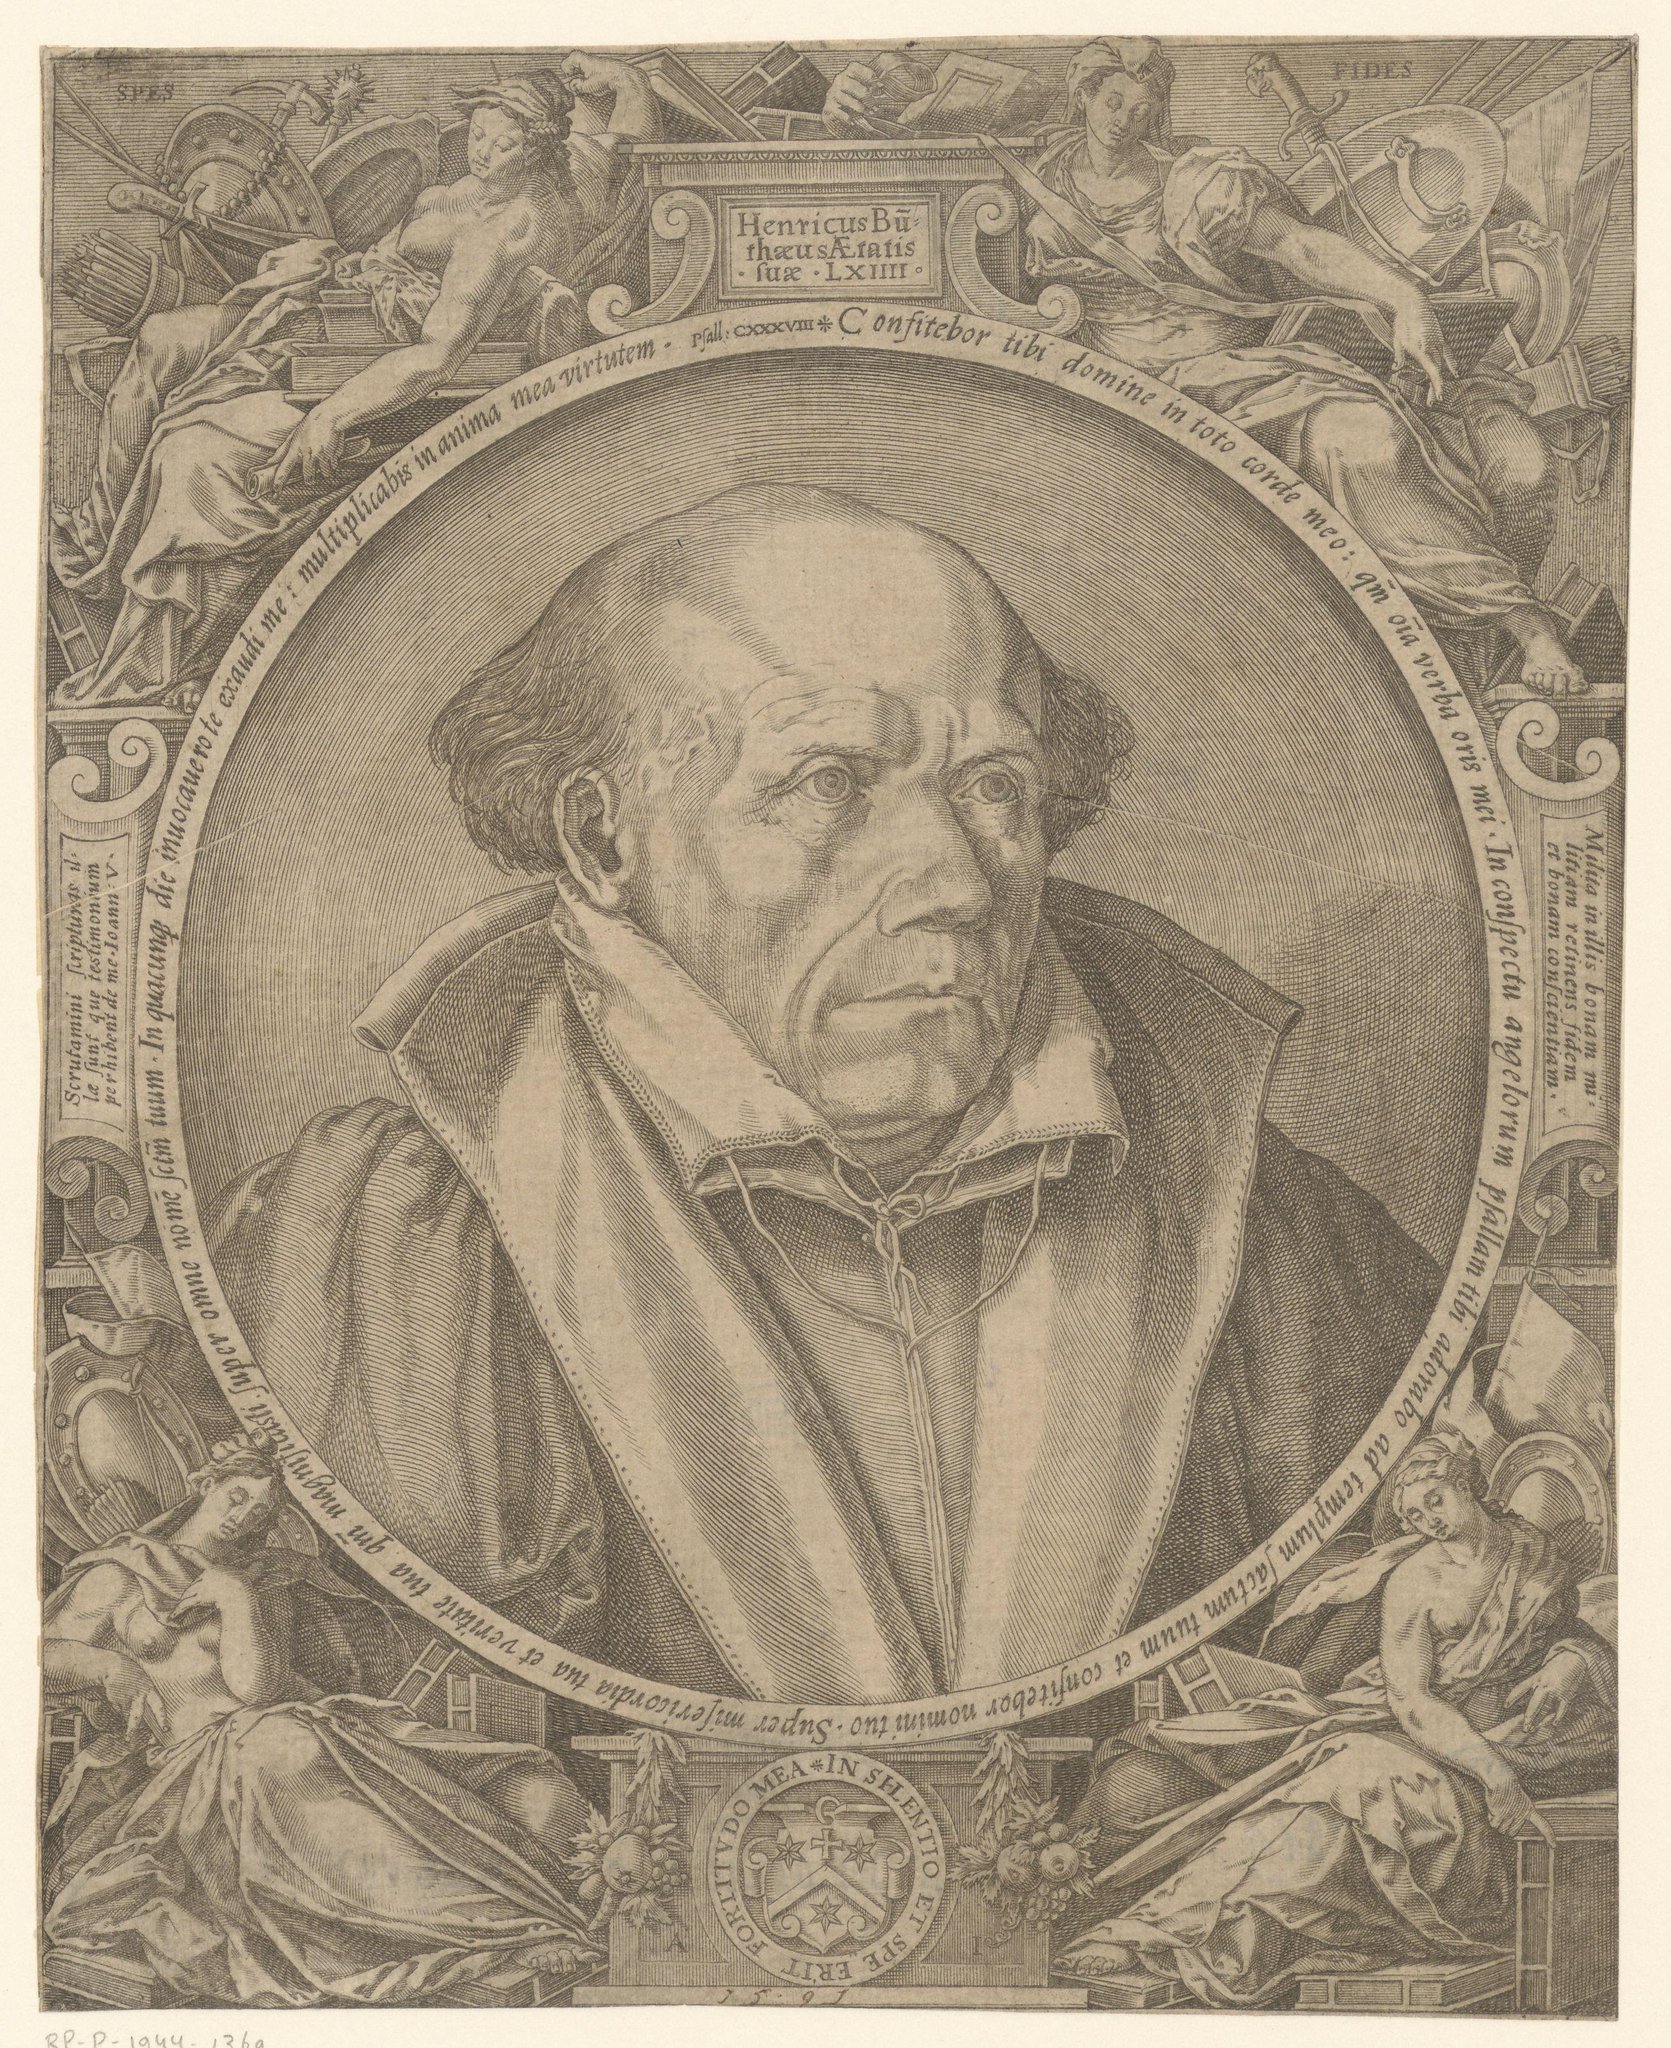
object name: print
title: Portret van Henricus Bunthaeus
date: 1591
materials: paper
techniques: engraving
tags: historical persons, weapons, book, armorial bearing, heraldry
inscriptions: inscription: ‘Erit fortitudo mea in silentio et spe’, collector's mark: Lugt 2228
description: In omlijsting met vier allegorische figuren te midden van wapens en boeken. Onder een wapenschild met het motto: 'In silentio et spe erit fortitudo mea'.